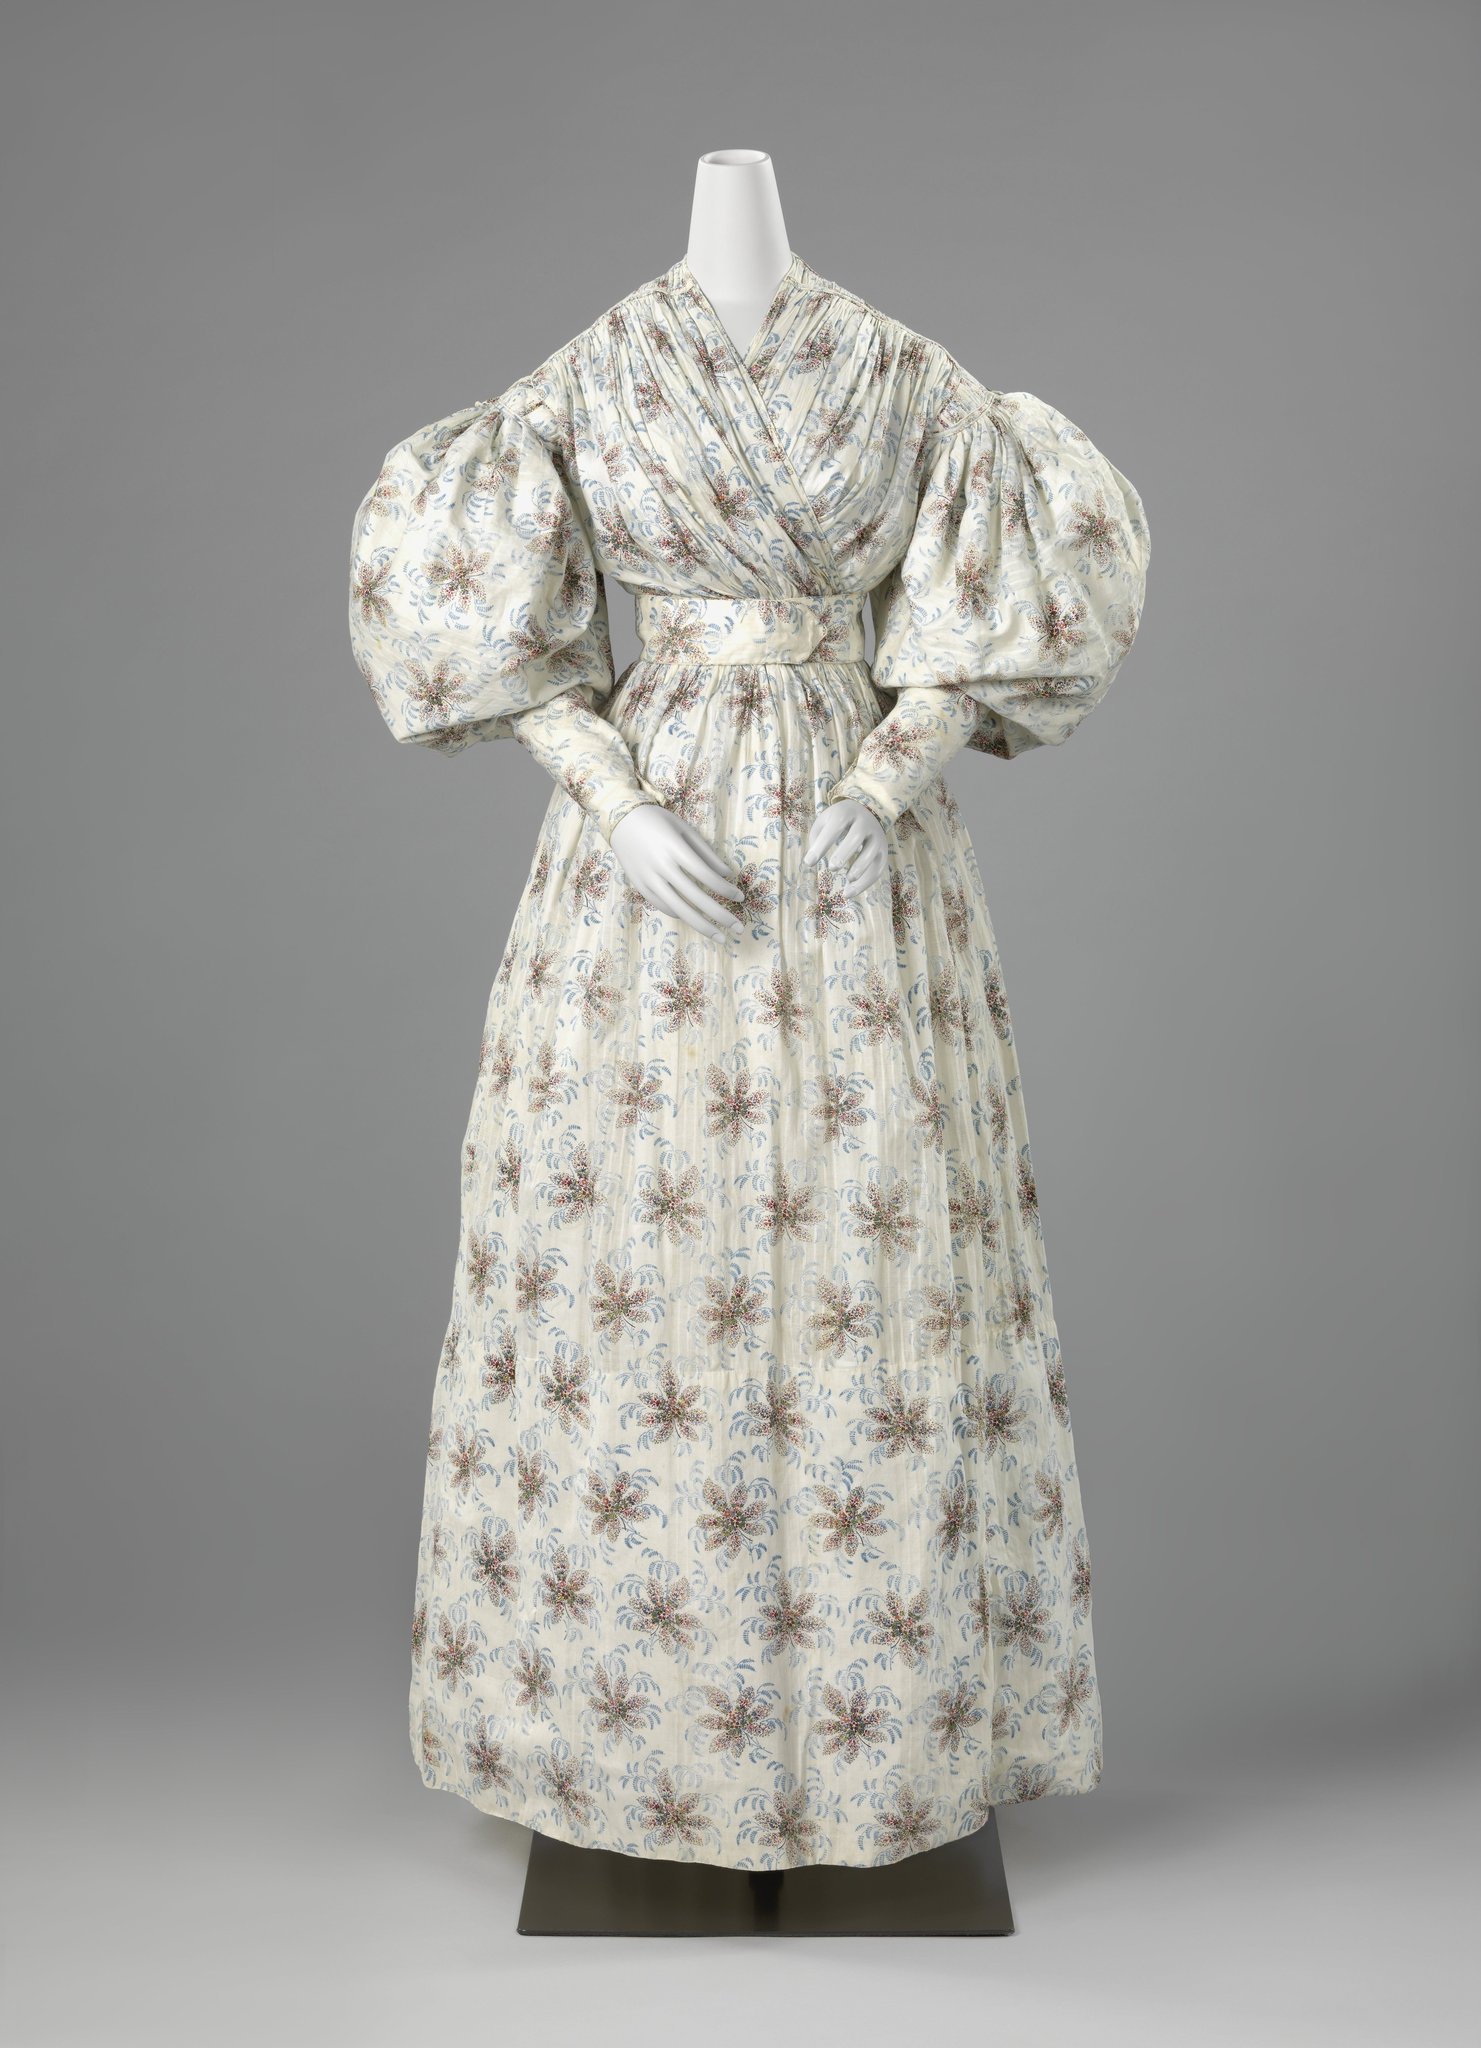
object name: robe, japon, jurk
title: Summer Dress of Printed Fabric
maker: Anonymous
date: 1830-1832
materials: cotton, metal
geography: netherlands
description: Typical of fashion in the 1830s is the so-called leg-ofmutton or gigot sleeve, puffing just below the shoulder and fitting closely around the forearms. This dress was probably worn, and also possibly made by the seamstress Anna Maria van den Bijllardt. It is crafted with utmost skill, and subtly decorated with fine pleats and piping made of the same fabric at the seams.